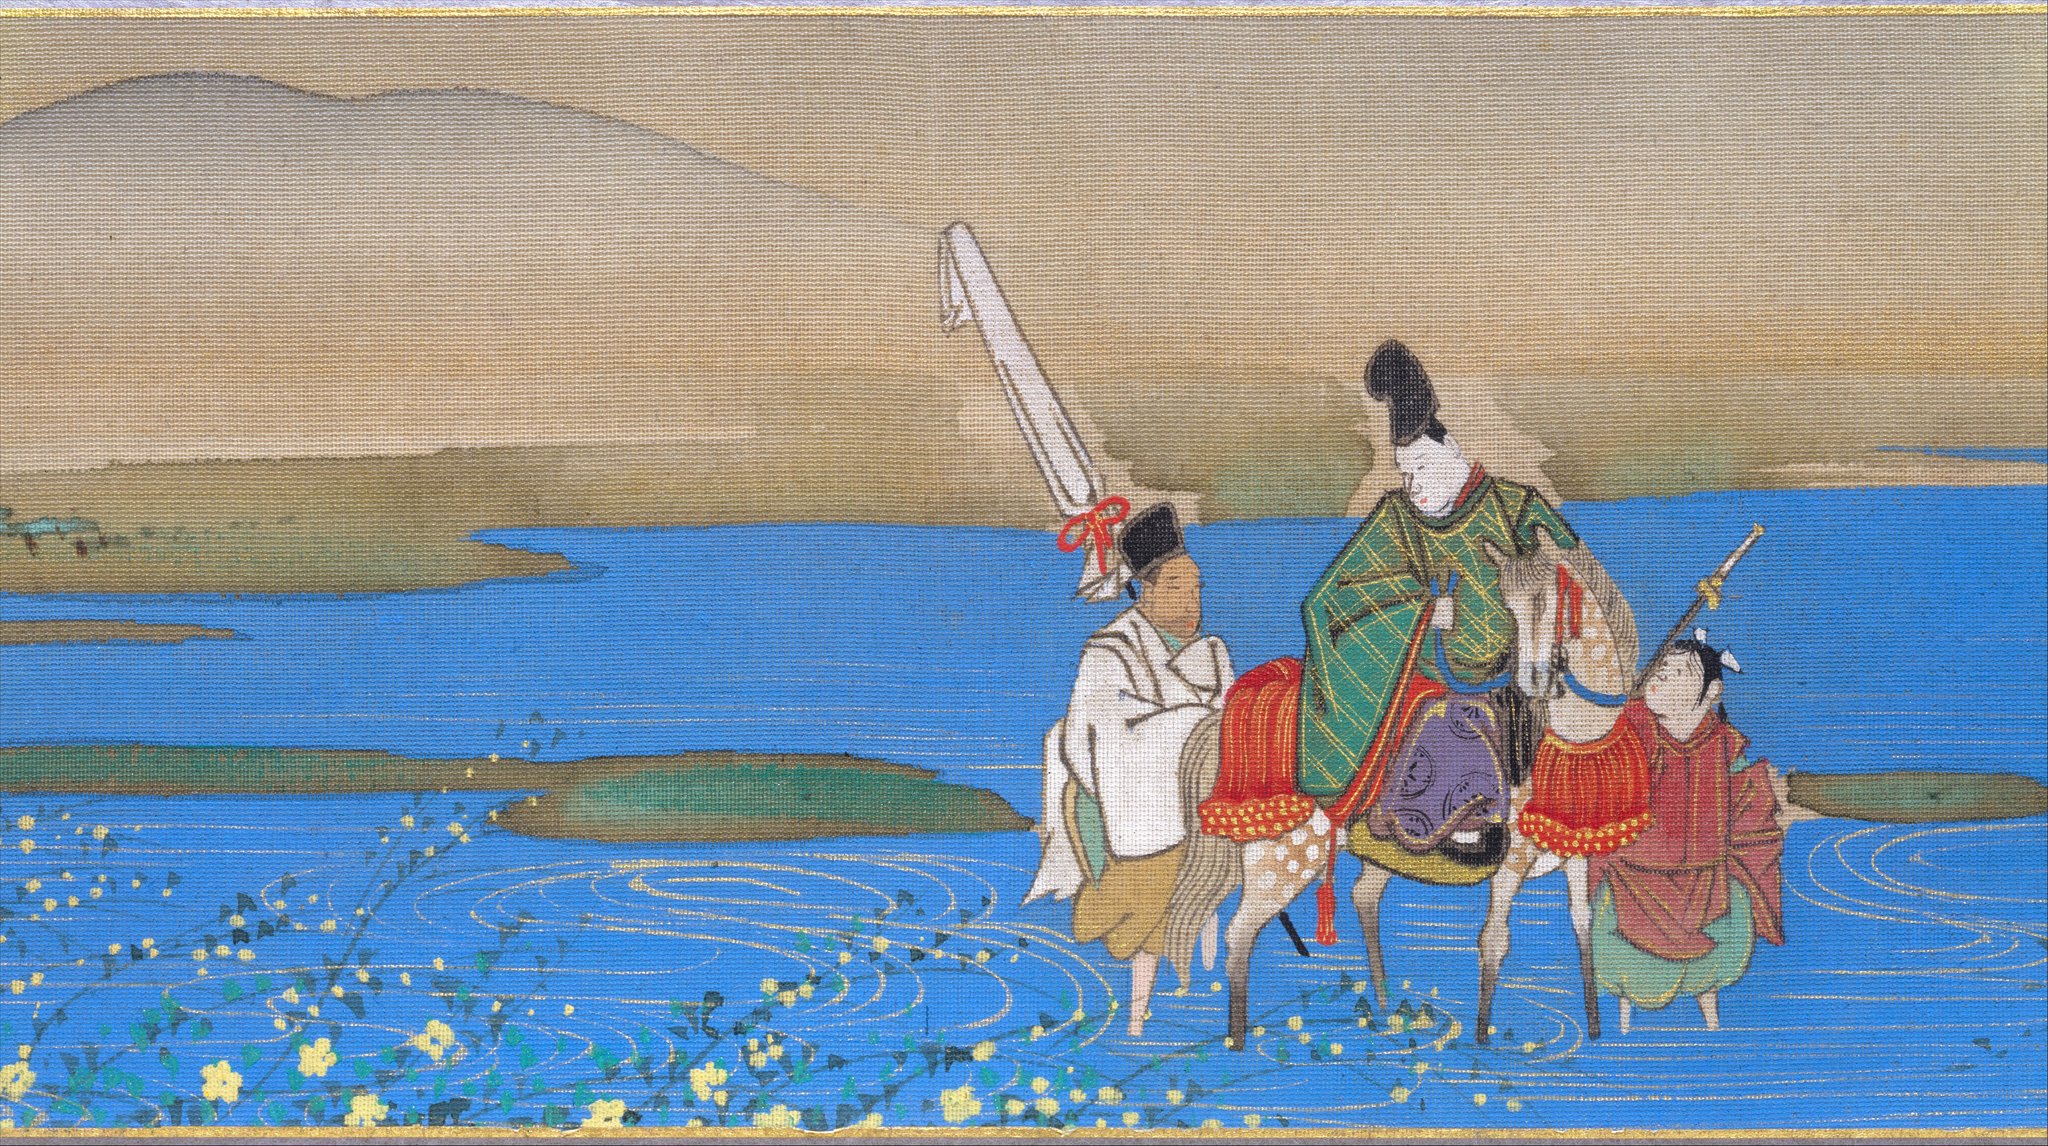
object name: handscroll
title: Six Jewel Rivers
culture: japanese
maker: sakai ōho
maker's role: artist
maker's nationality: japanese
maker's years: 1808-1841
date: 1839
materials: gold, ink, silk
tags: men,rivers,landscapes